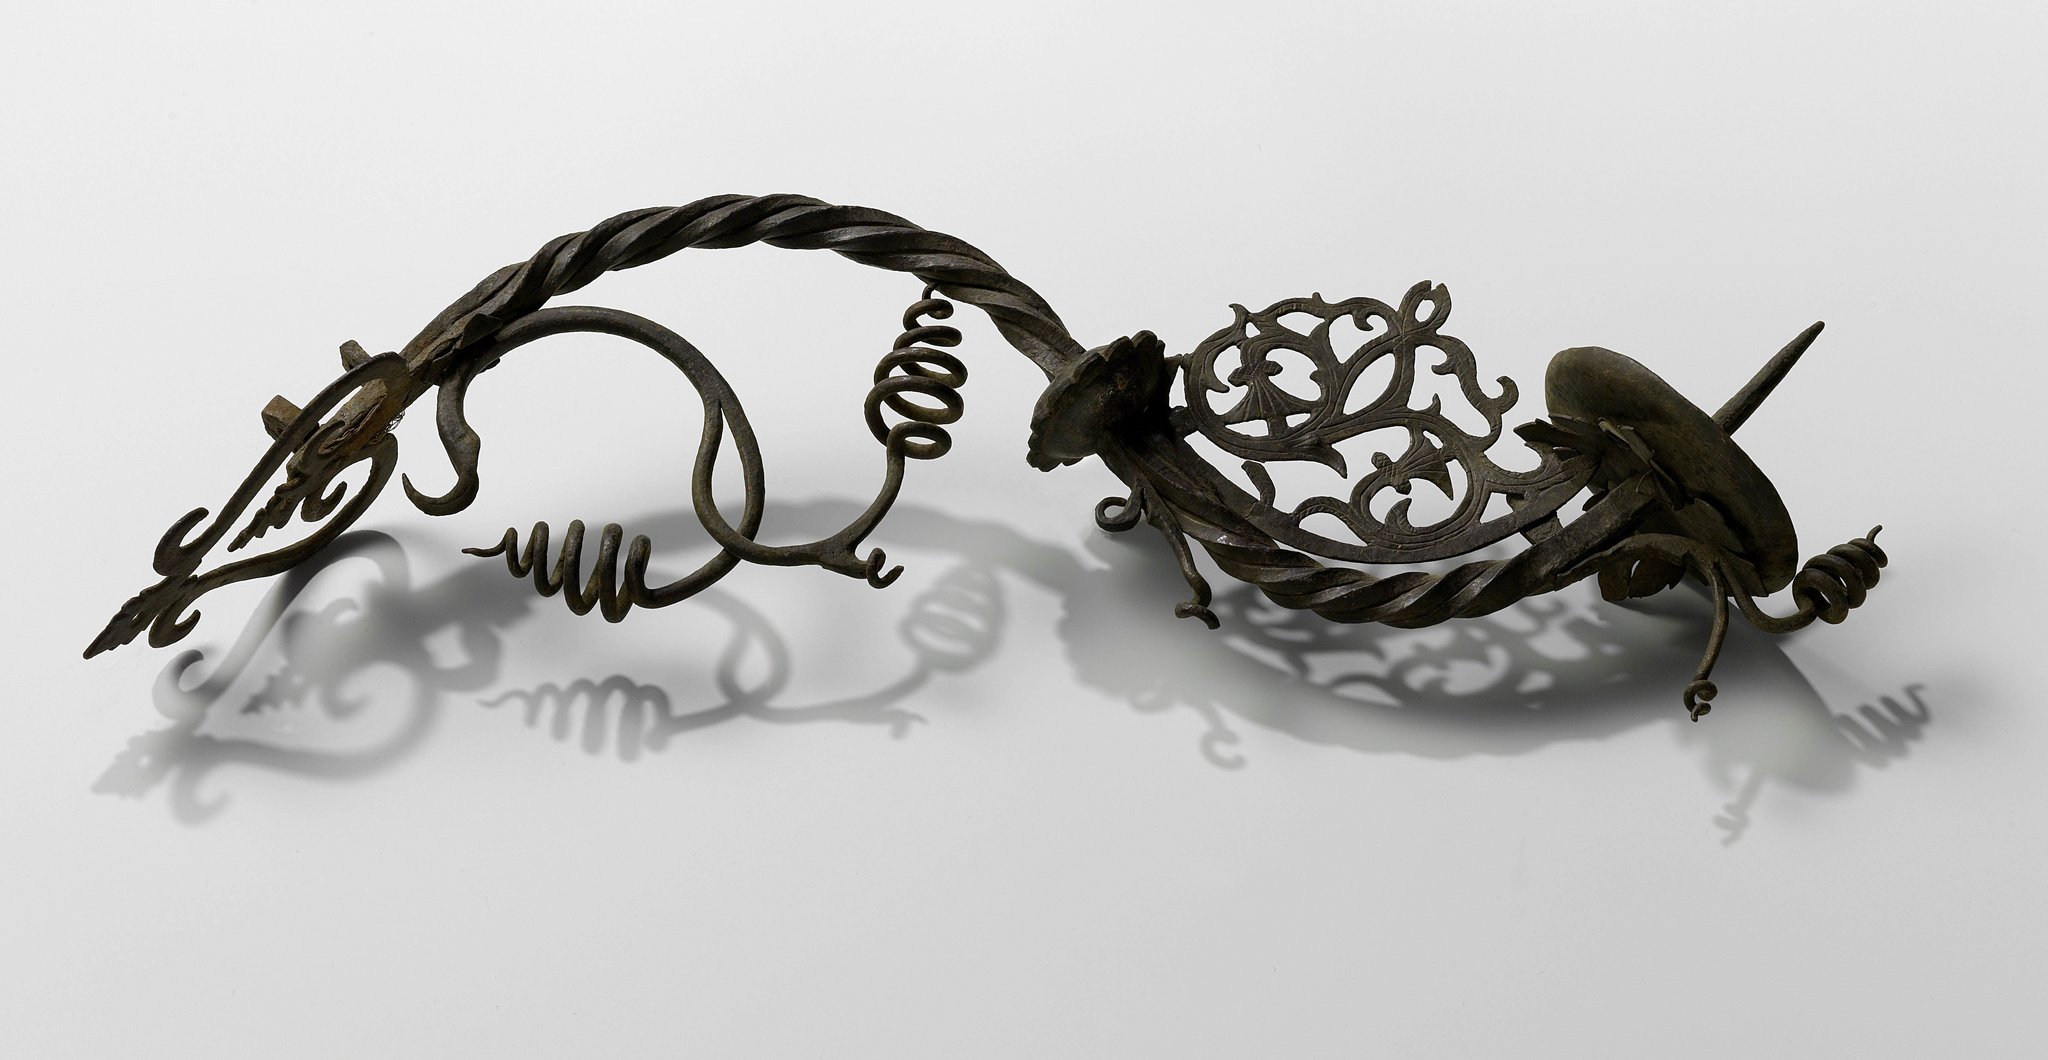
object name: lichtarm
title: Lichtarm van gesmeed ijzer, getordeerd en S-vormig gebogen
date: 1500-1525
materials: iron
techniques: forging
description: Een gesmeed ijzeren lichtarm getordeerd en in S-vorm gebogen; op de helft voorzien van een getande knoop waarboven een rijk bladornament en waaronder een zich splitsende tak, eindigend in twee spiralen.